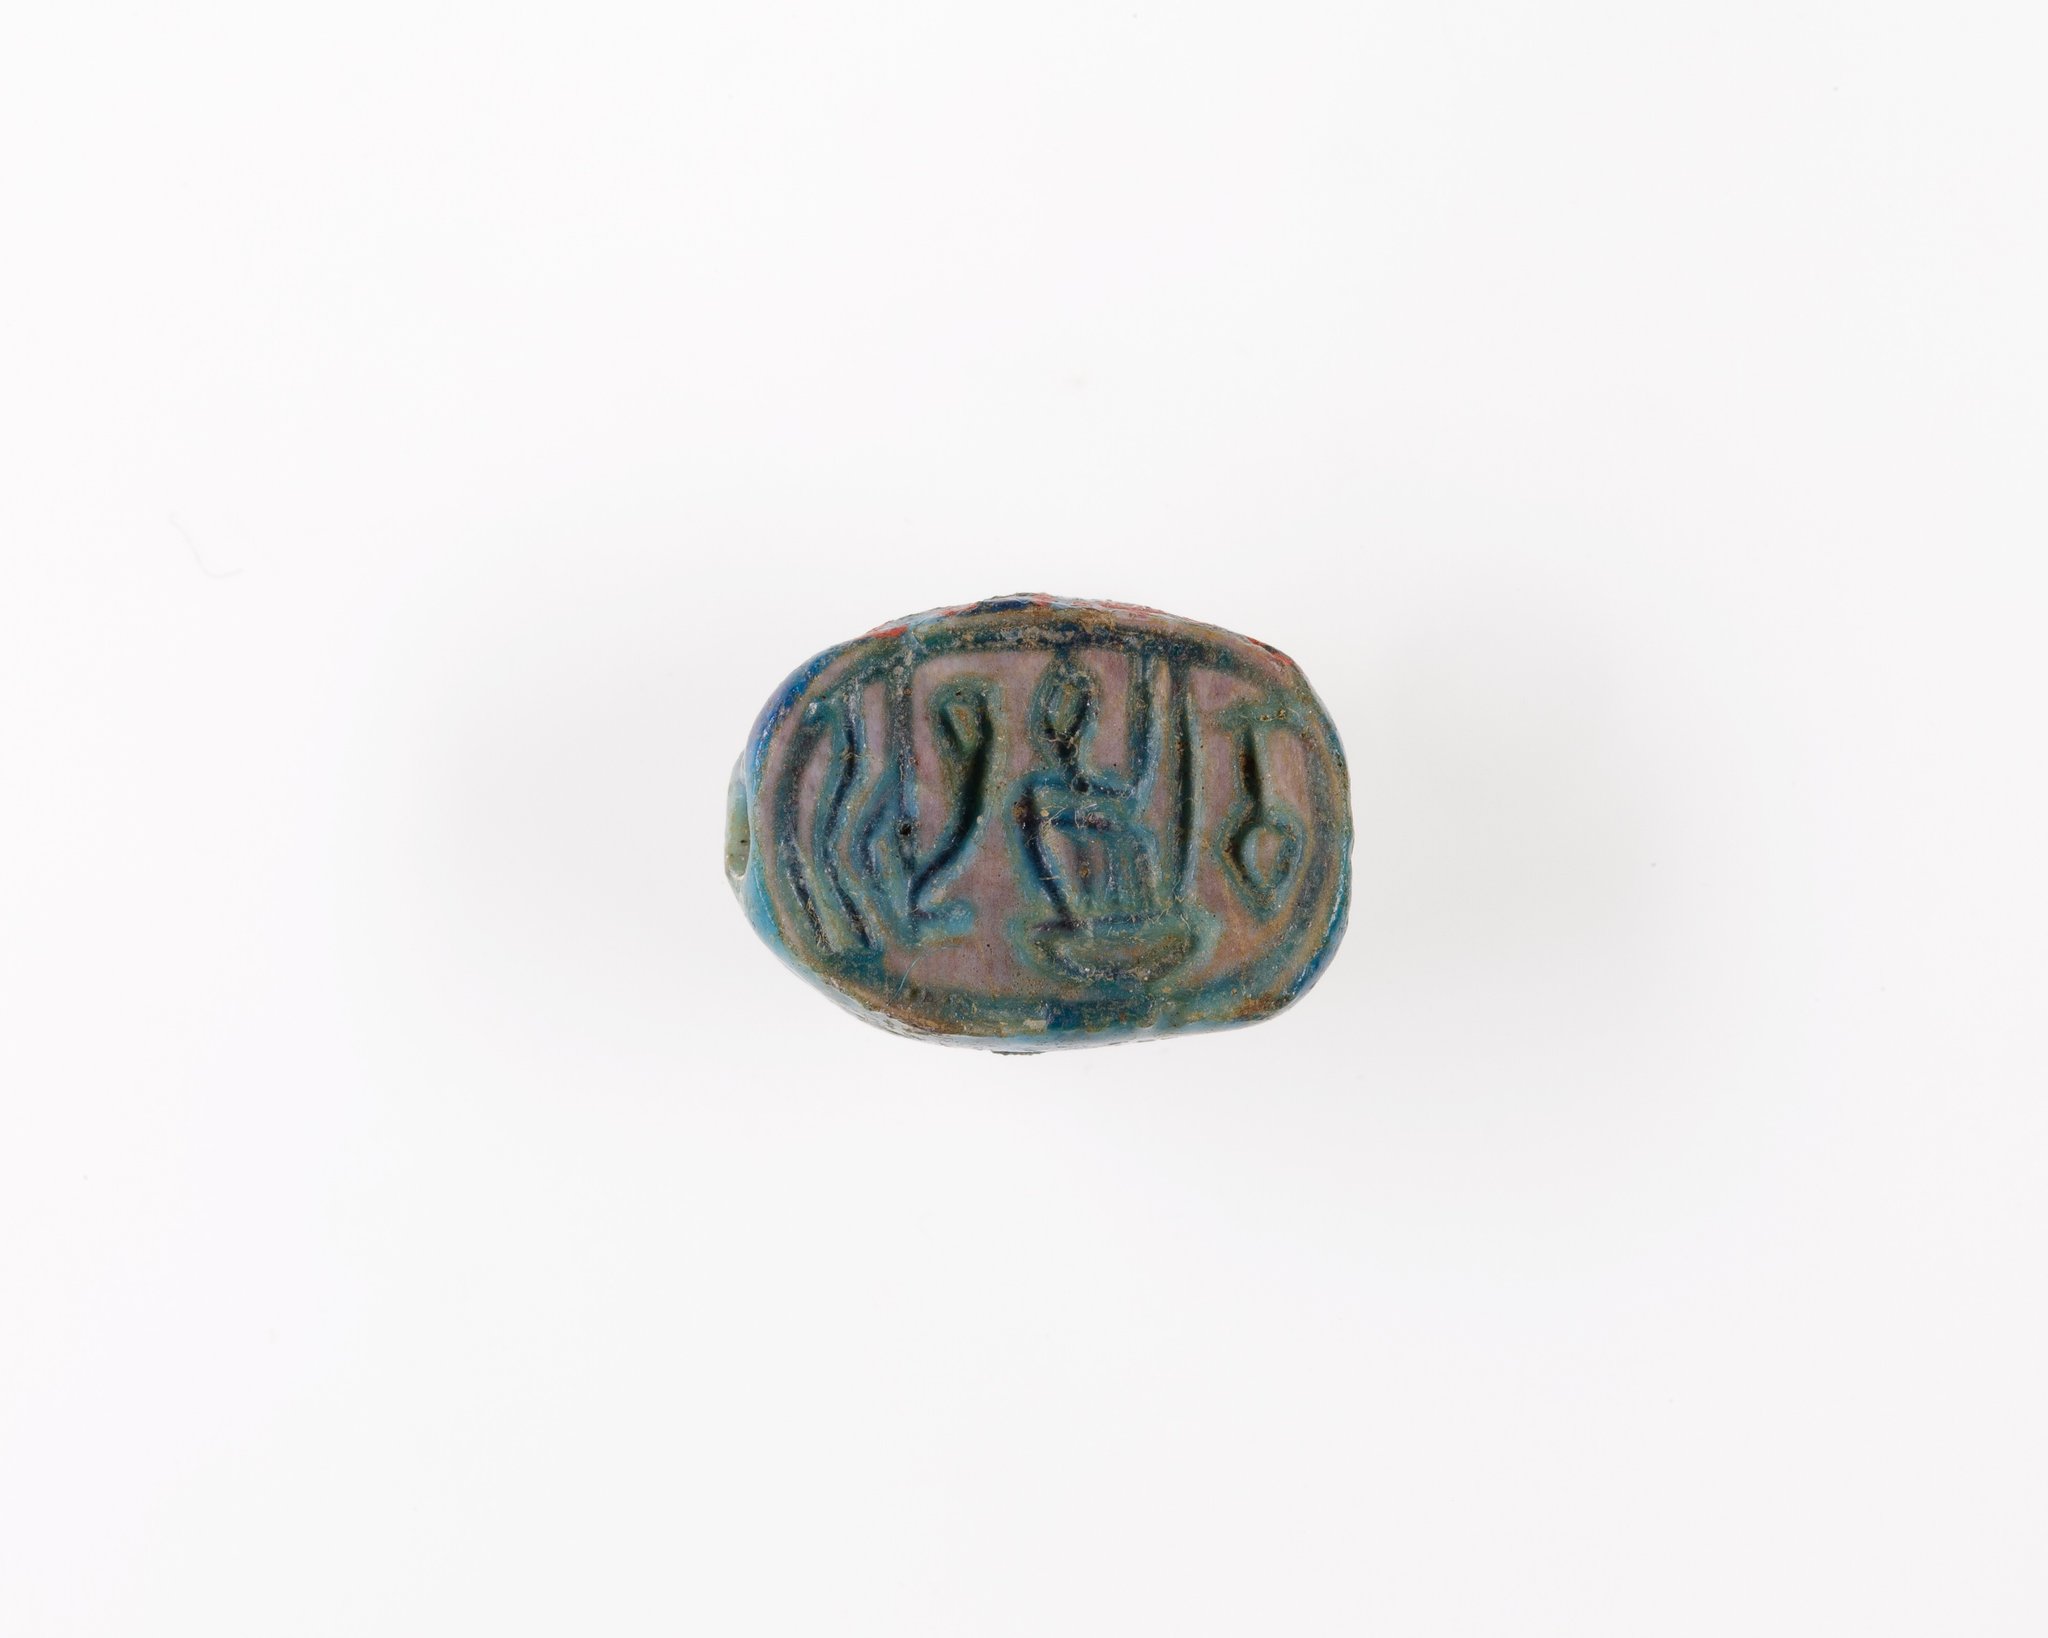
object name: scarabm hieroglyph, wedjat, nefer, red crown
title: Scarab Inscribed with Hieroglyphs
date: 1740-1640 BCE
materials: stone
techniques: glazing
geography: egypt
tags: scarabs